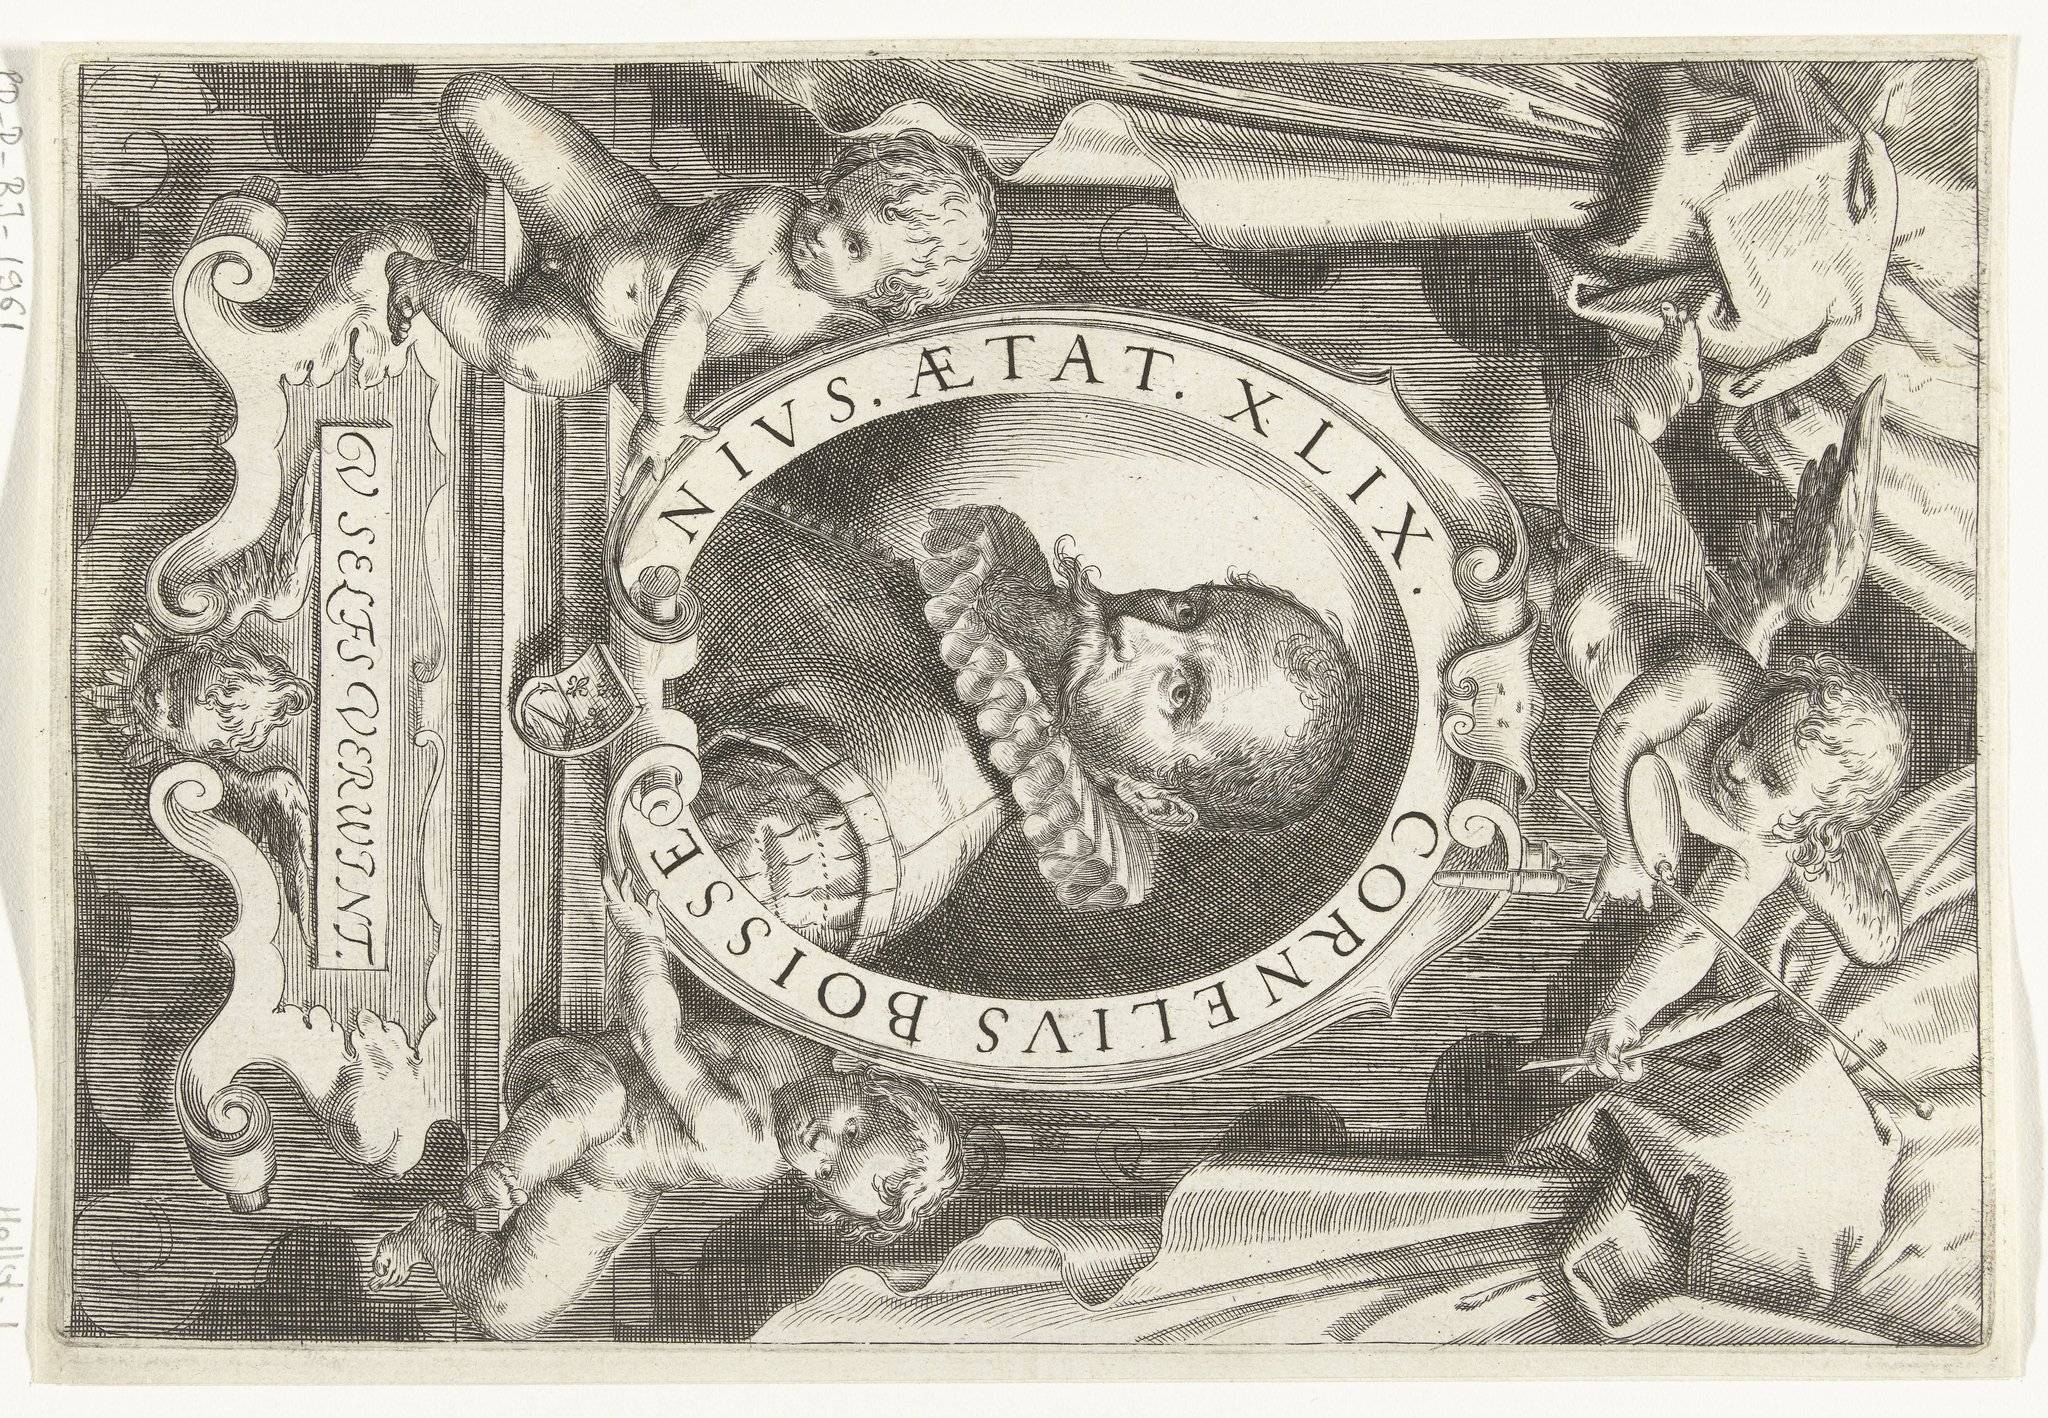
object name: print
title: Zelfportret op 59-jarige leeftijd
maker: cornelis dircksz. boissens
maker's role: draughtsman, print maker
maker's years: 1567-1635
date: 1626-1627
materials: paper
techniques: engraving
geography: leiden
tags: enkhuizen, leiden, print maker, draughtsman, cornelis dircksz. boissens, portrait, self-portrait of painter, cupids: 'amores', 'amoretti', 'putti', armorial bearing, heraldry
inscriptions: collector's mark: Lugt 2228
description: Portretbuste van Cornelis Dircksz. Boissens naar links, in ovaal met randschrift. De ovale lijst wordt vastgehouden door twee putti. Een derde putto zweeft erboven met de attributen van de schilder in zijn handen. Met motto in cartouche onder portret: U Selfs Verwint.